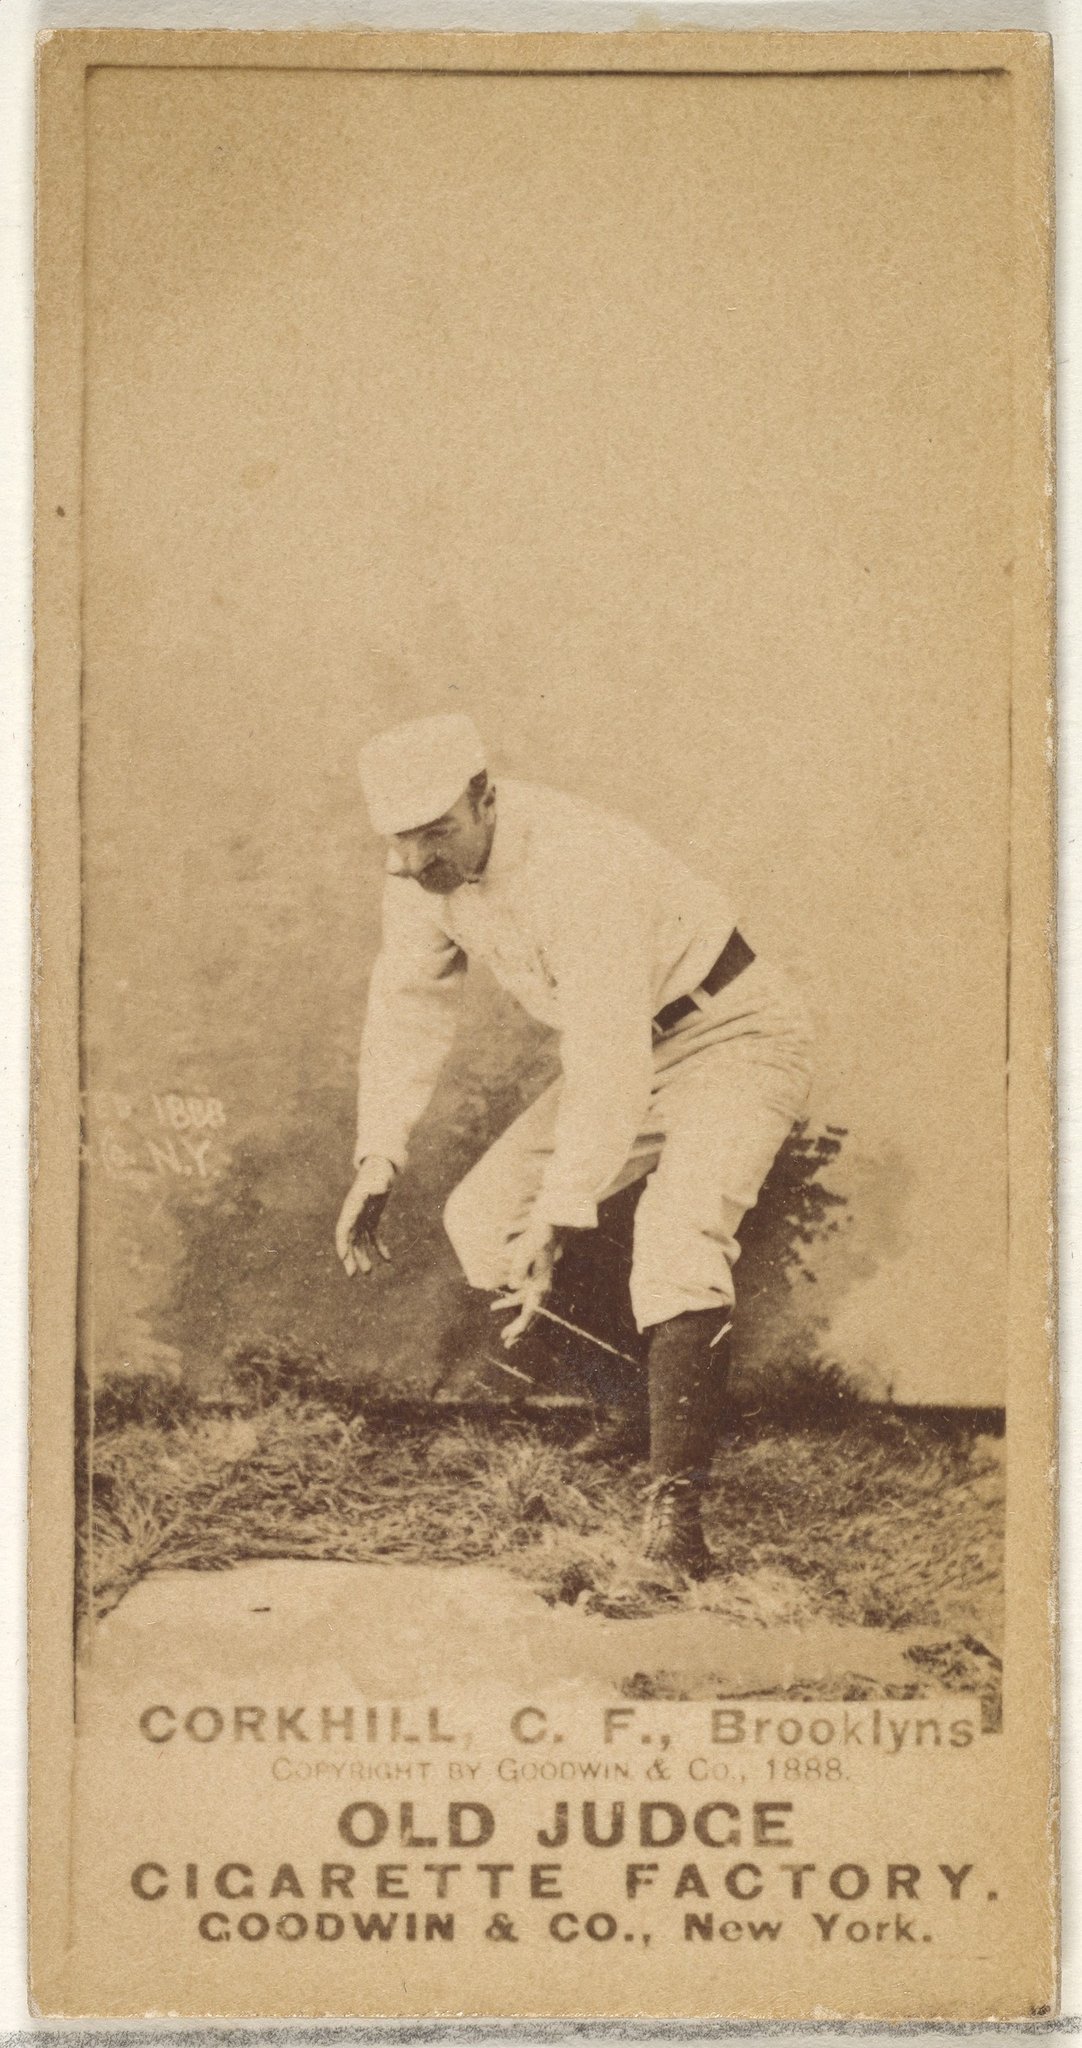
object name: baseball card, photograph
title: Corkhill, Center Field, Brooklyn Bridegrooms, from the Old Judge series (N172) for Old Judge Cigarettes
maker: goodwin & company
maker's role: publisher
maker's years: 1850-1950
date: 1888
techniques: albumen silver print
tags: men,portraits,baseball,athletes